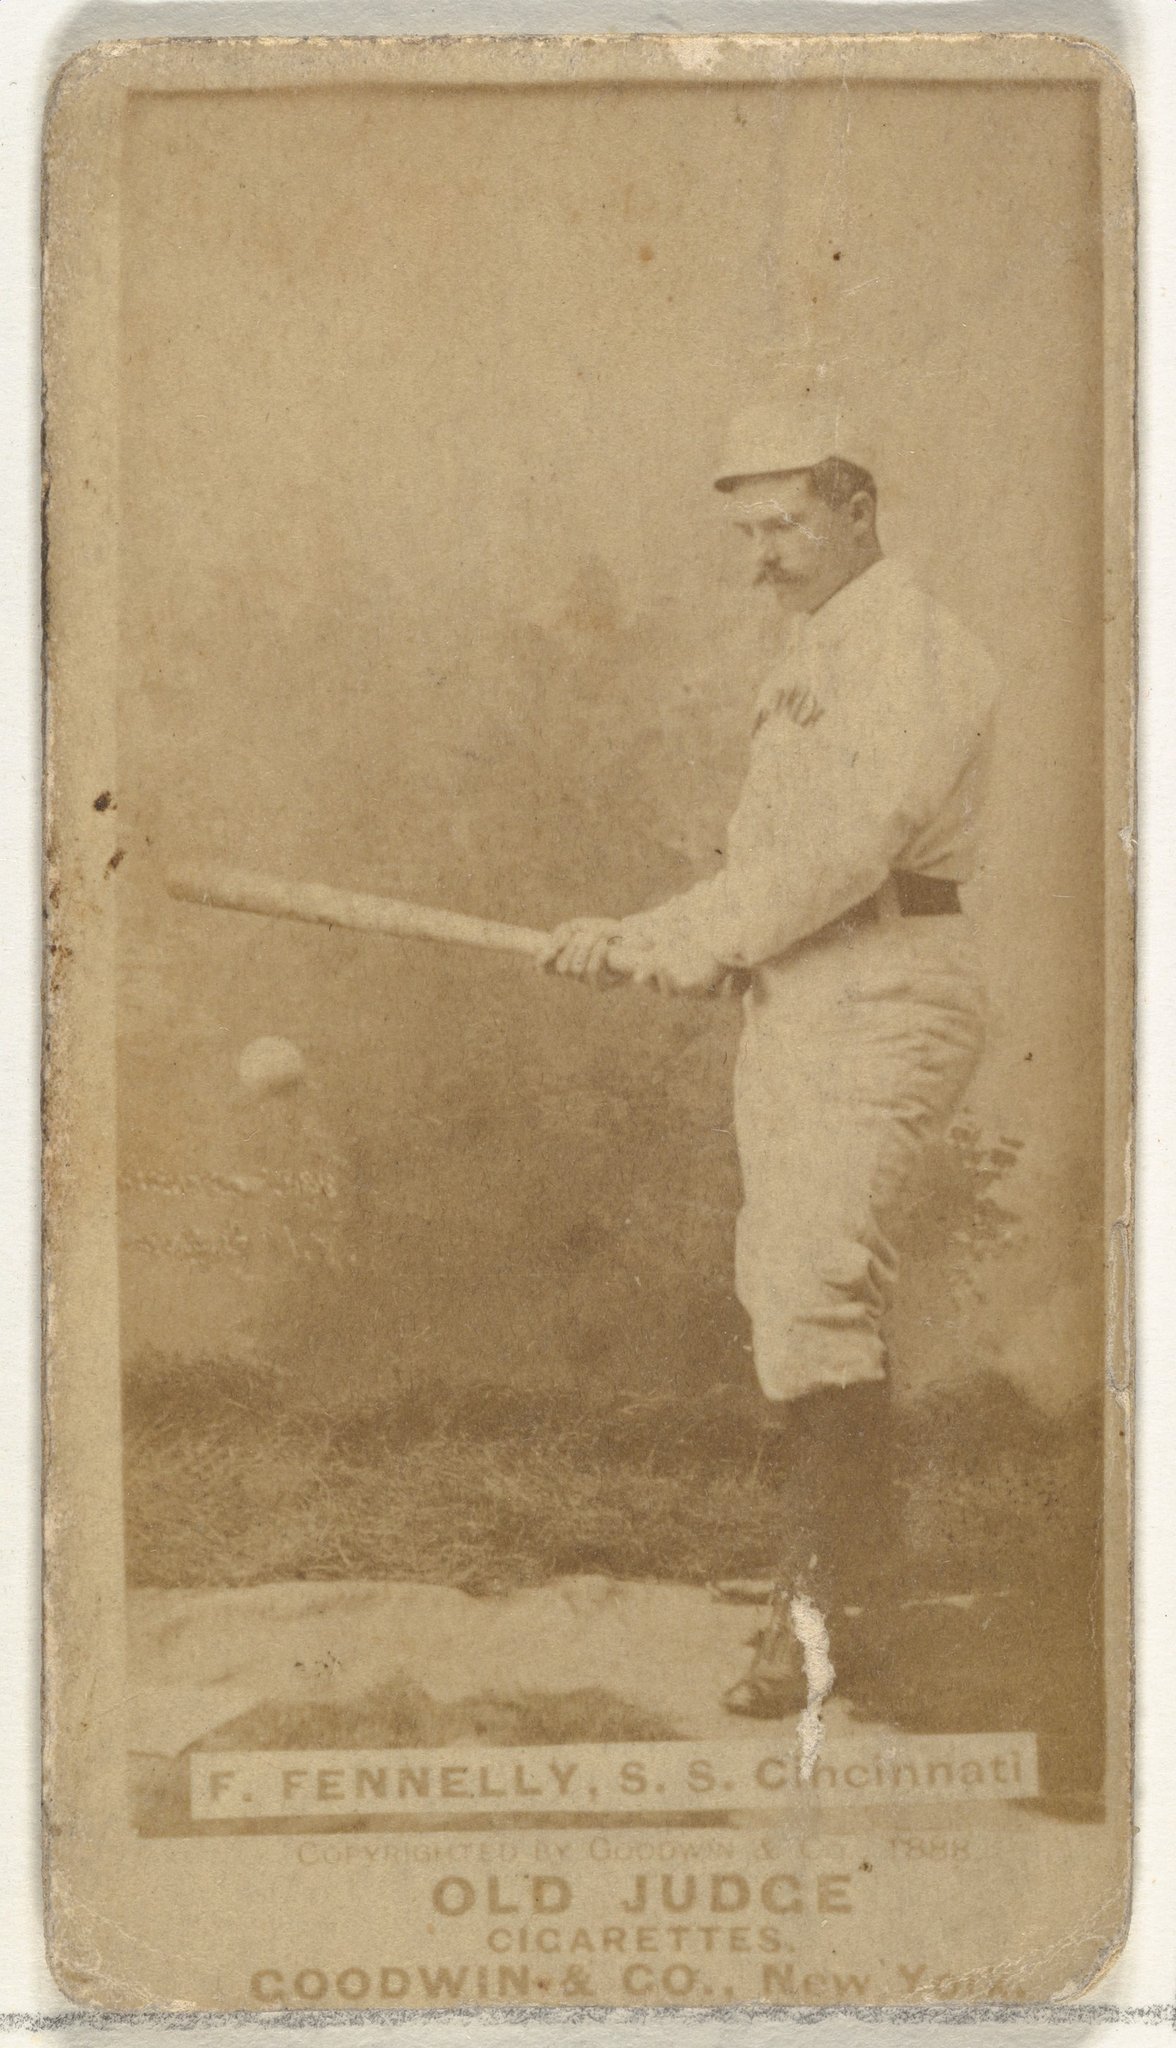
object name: baseball card, photograph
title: Francis John "Frank" Fennelly, Shortstop, Cincinnati, from the Old Judge series (N172) for Old Judge Cigarettes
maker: goodwin & company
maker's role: publisher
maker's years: 1850-1950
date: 1888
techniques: albumen silver print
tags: men,portraits,baseball,athletes